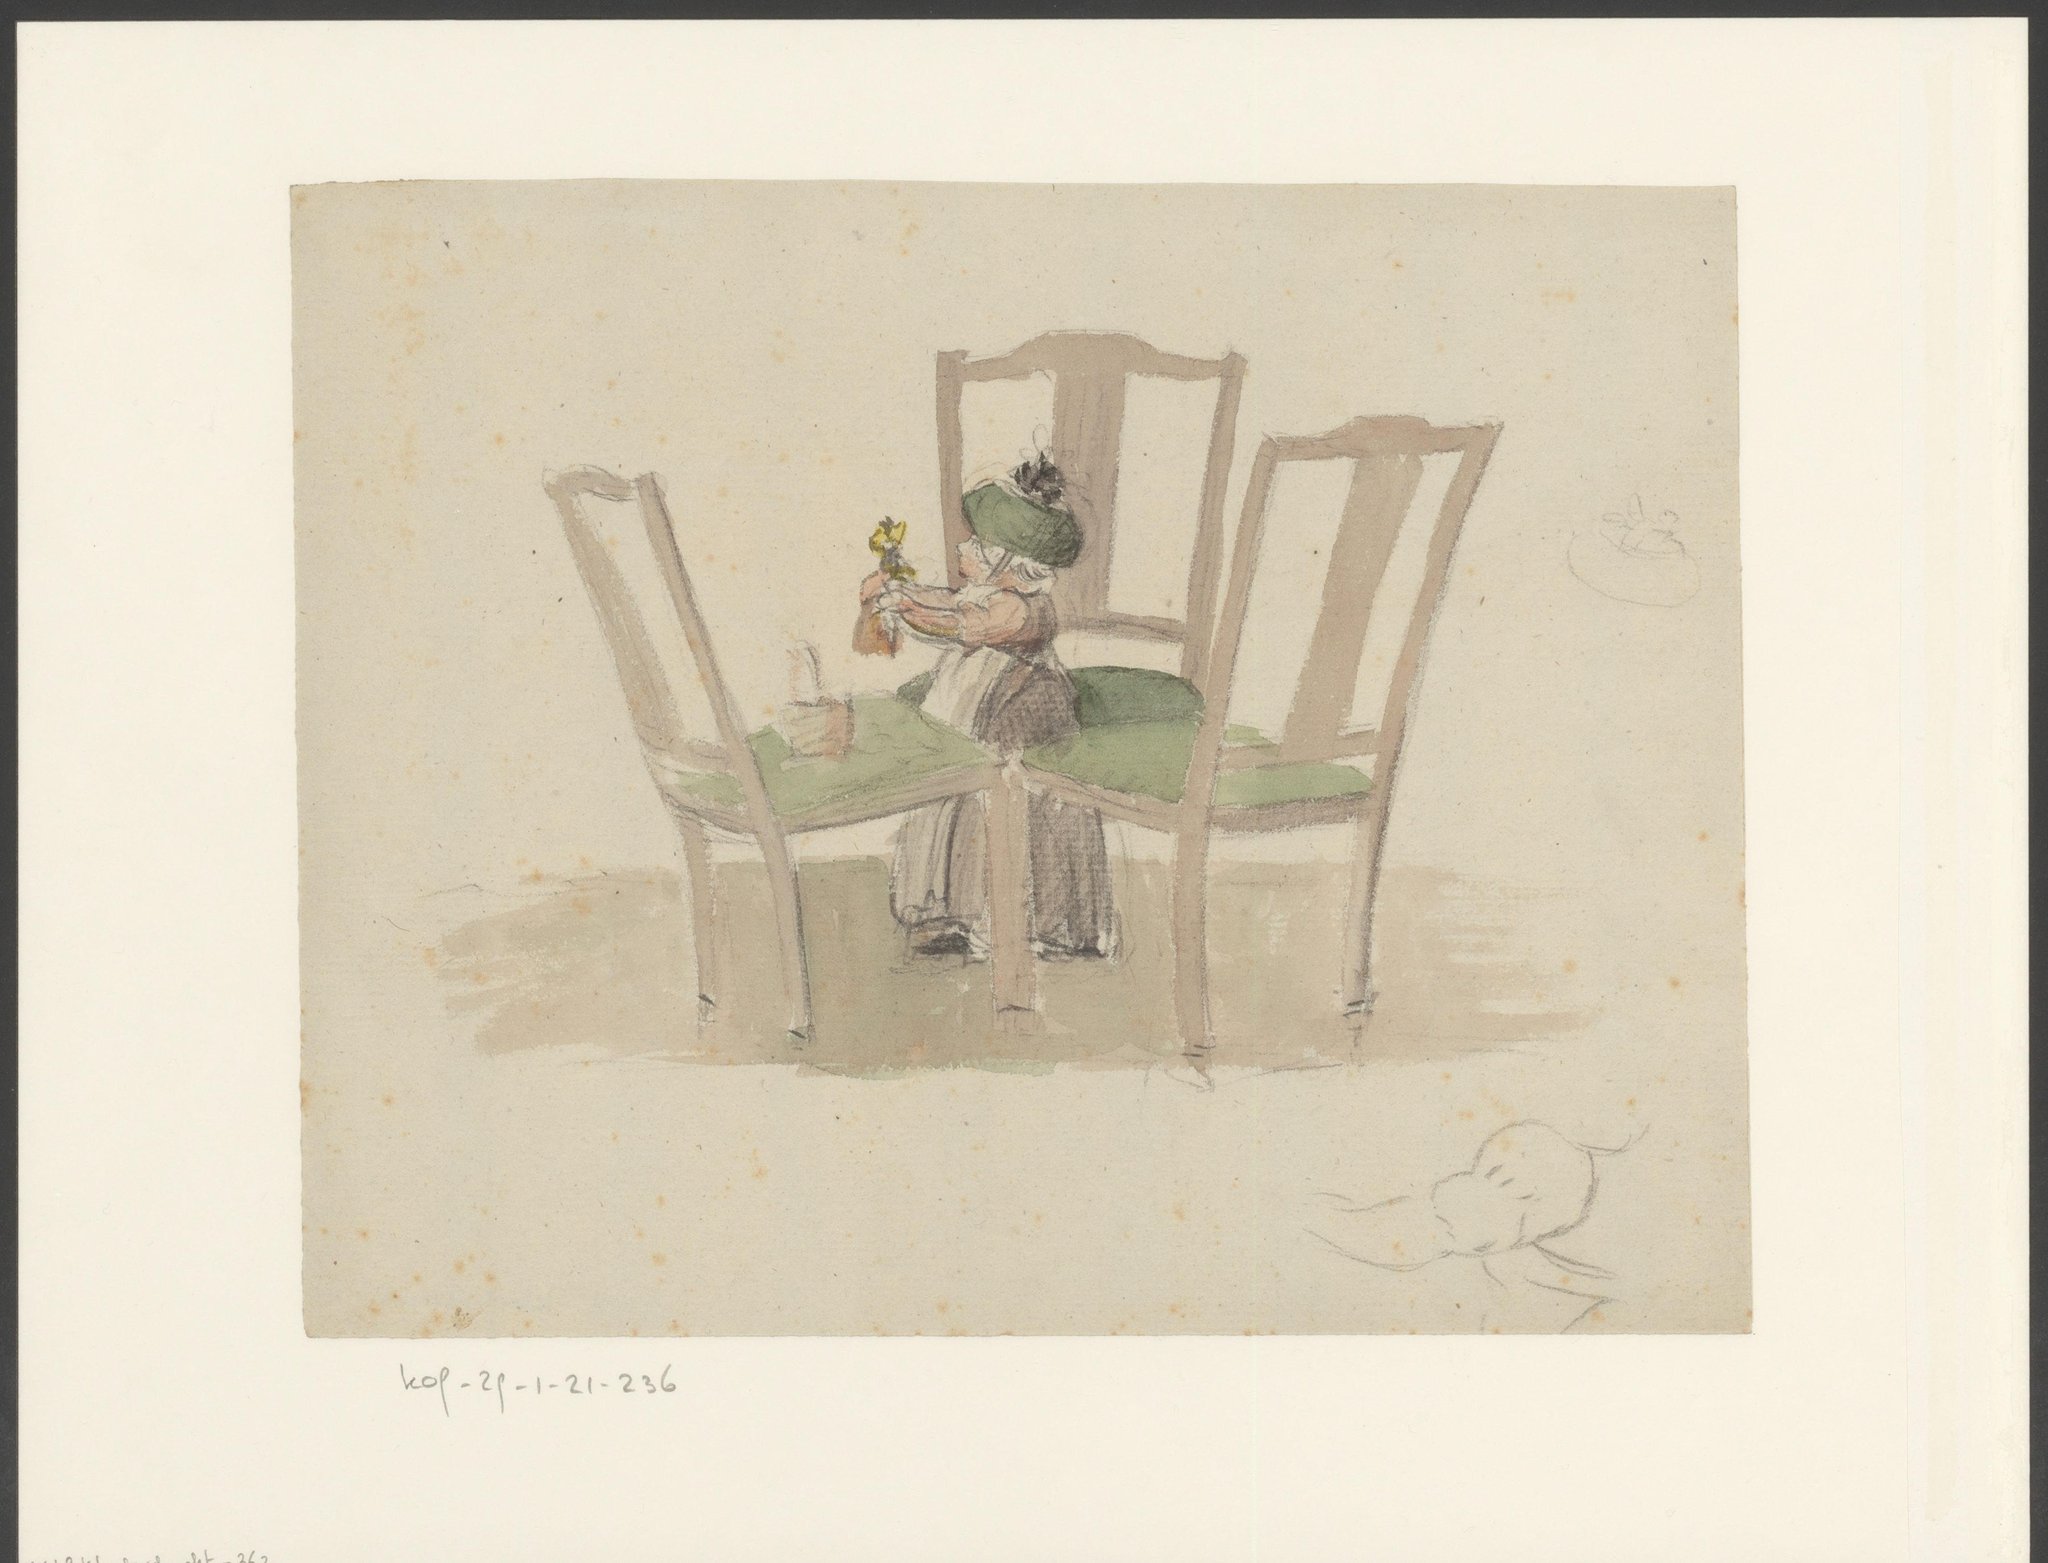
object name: drawing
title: Kind met valhelm staat tussen drie stoelen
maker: Anonymous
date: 1800-1839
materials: chalk, paper, watercolor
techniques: brush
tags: child, container made of plant material other than wood: basket, dress, gown, chair, head-protector (~ learning to walk)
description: Onderwerpsrubrieken binnen de Atlas Zeden en Gewoonten: Zeden en Gewoonten in Engeren Zin, De Kleeding, Kleederdrachten (tijdvakken), Het begin der 19de eeuw. Mannen en vrouwen.